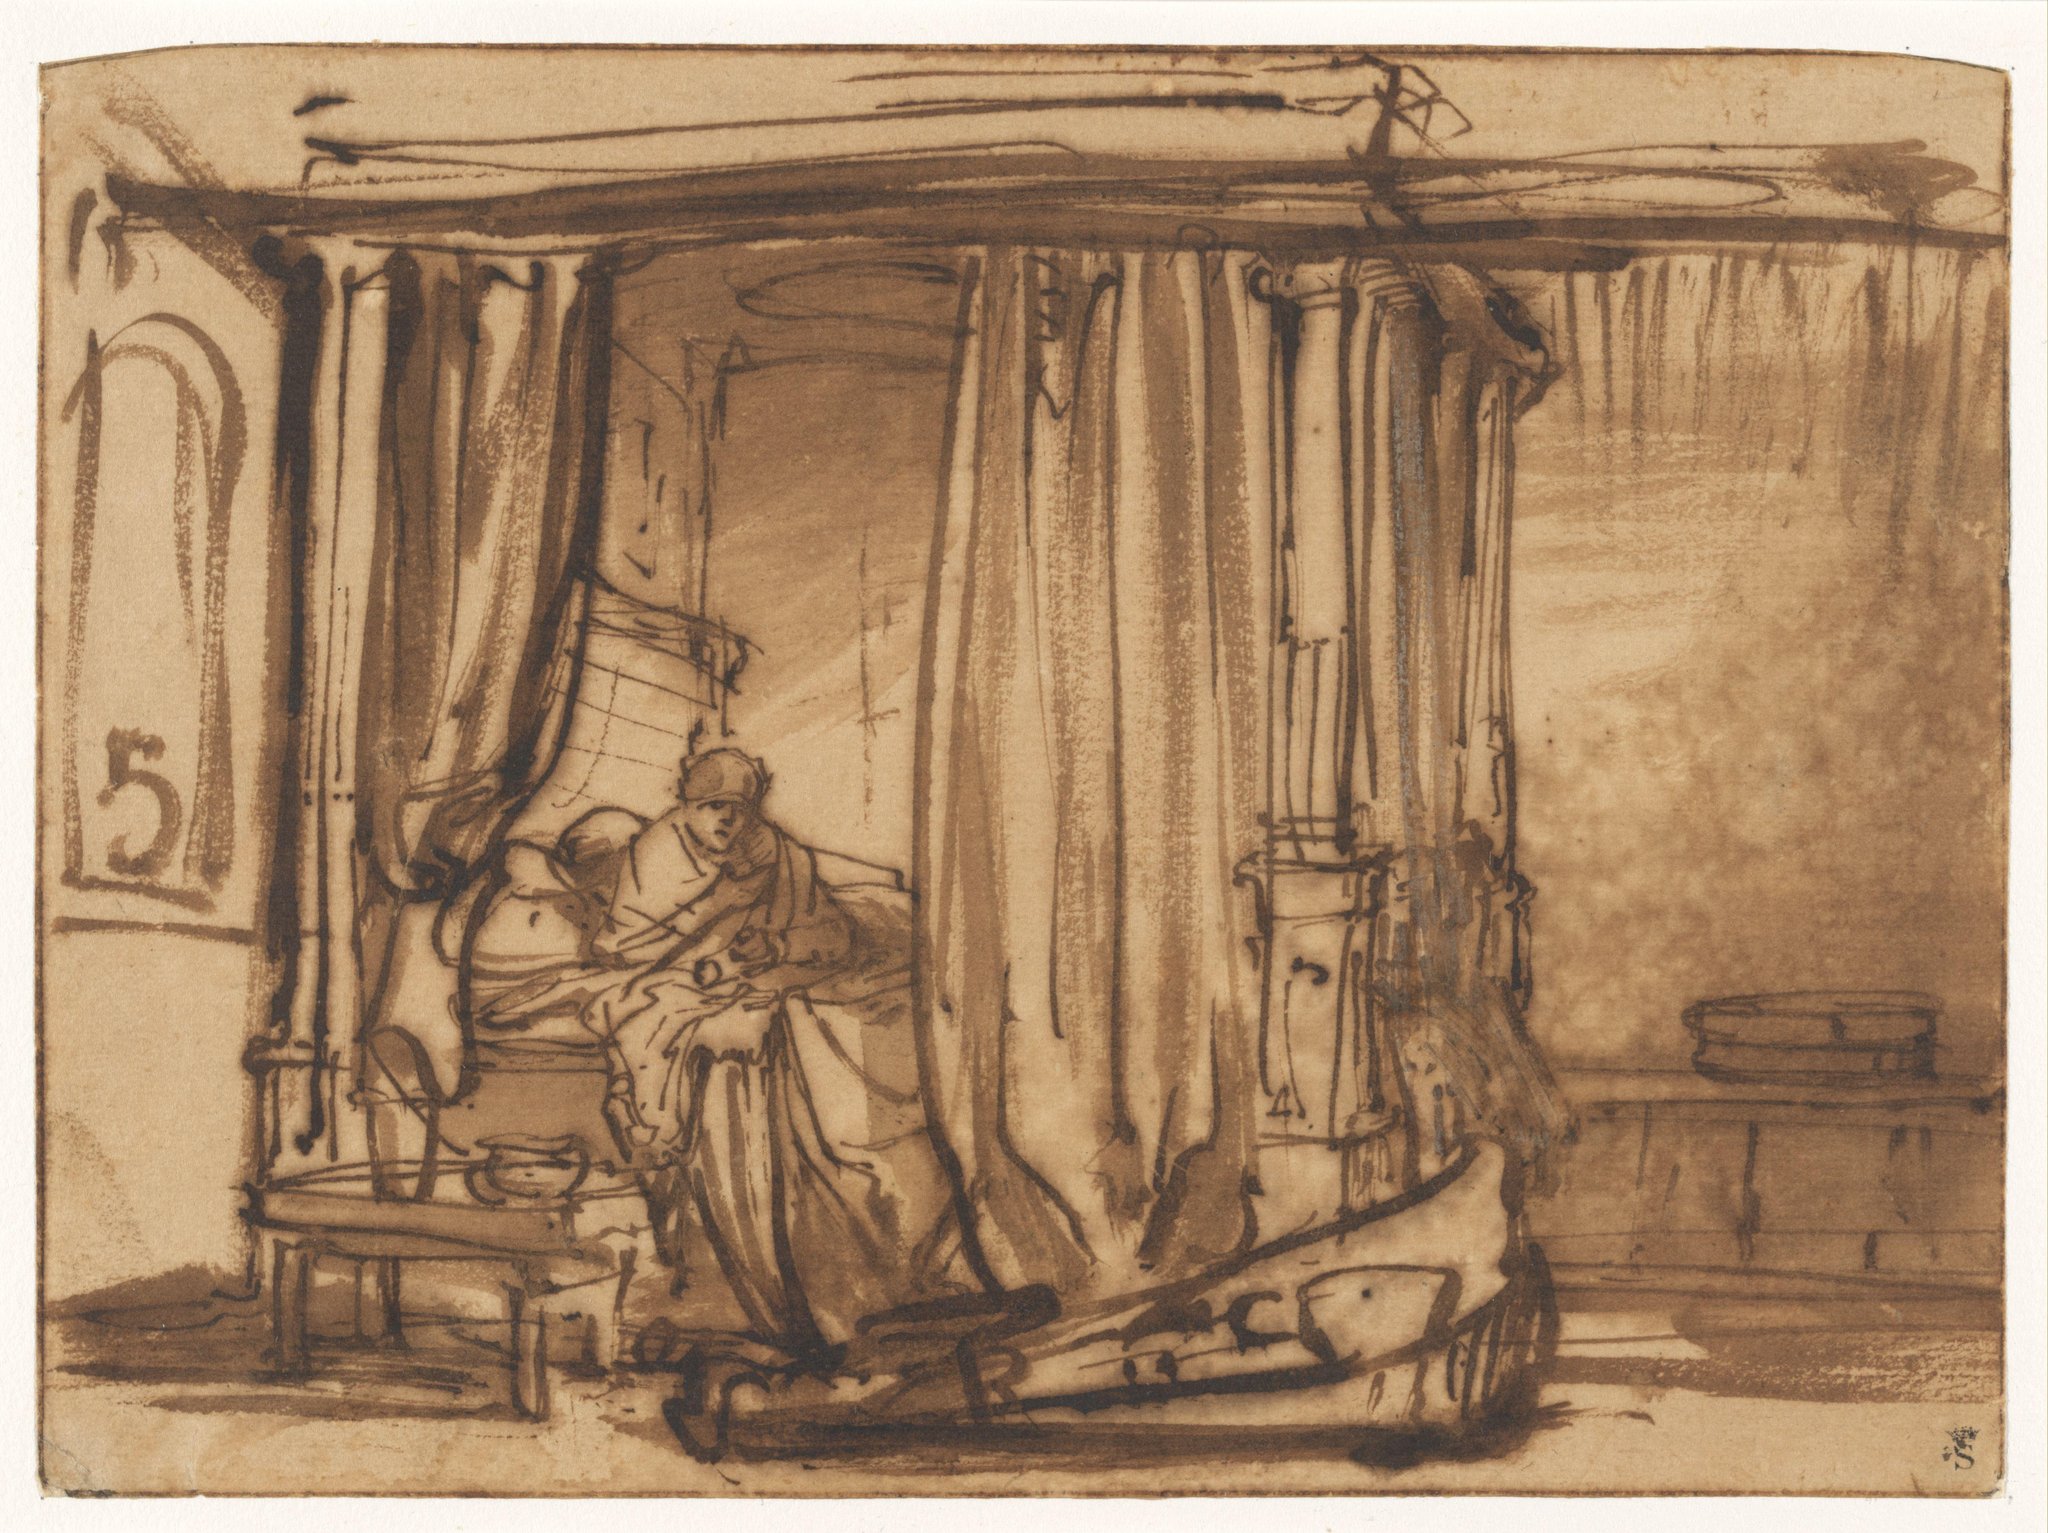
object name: drawing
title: Bedroom with Saskia in a Canopy Bed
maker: rembrandt van rijn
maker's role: draughtsman, painter, print maker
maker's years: 1606-1669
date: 1638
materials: ink, paint, paper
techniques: brush, pen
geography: amsterdam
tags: bed with tester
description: Rembrandt’s wife, Saskia, sits upright in a canopy bed with heavy curtains. She looks pallid and is probably pregnant, given the nursing couch on the ground. These were usually made of wicker and had a cushion against which the woman could lean when nursing a baby. Saskia is probably pregnant with their first daughter, Cornelia, who lived only three weeks from July 1638.